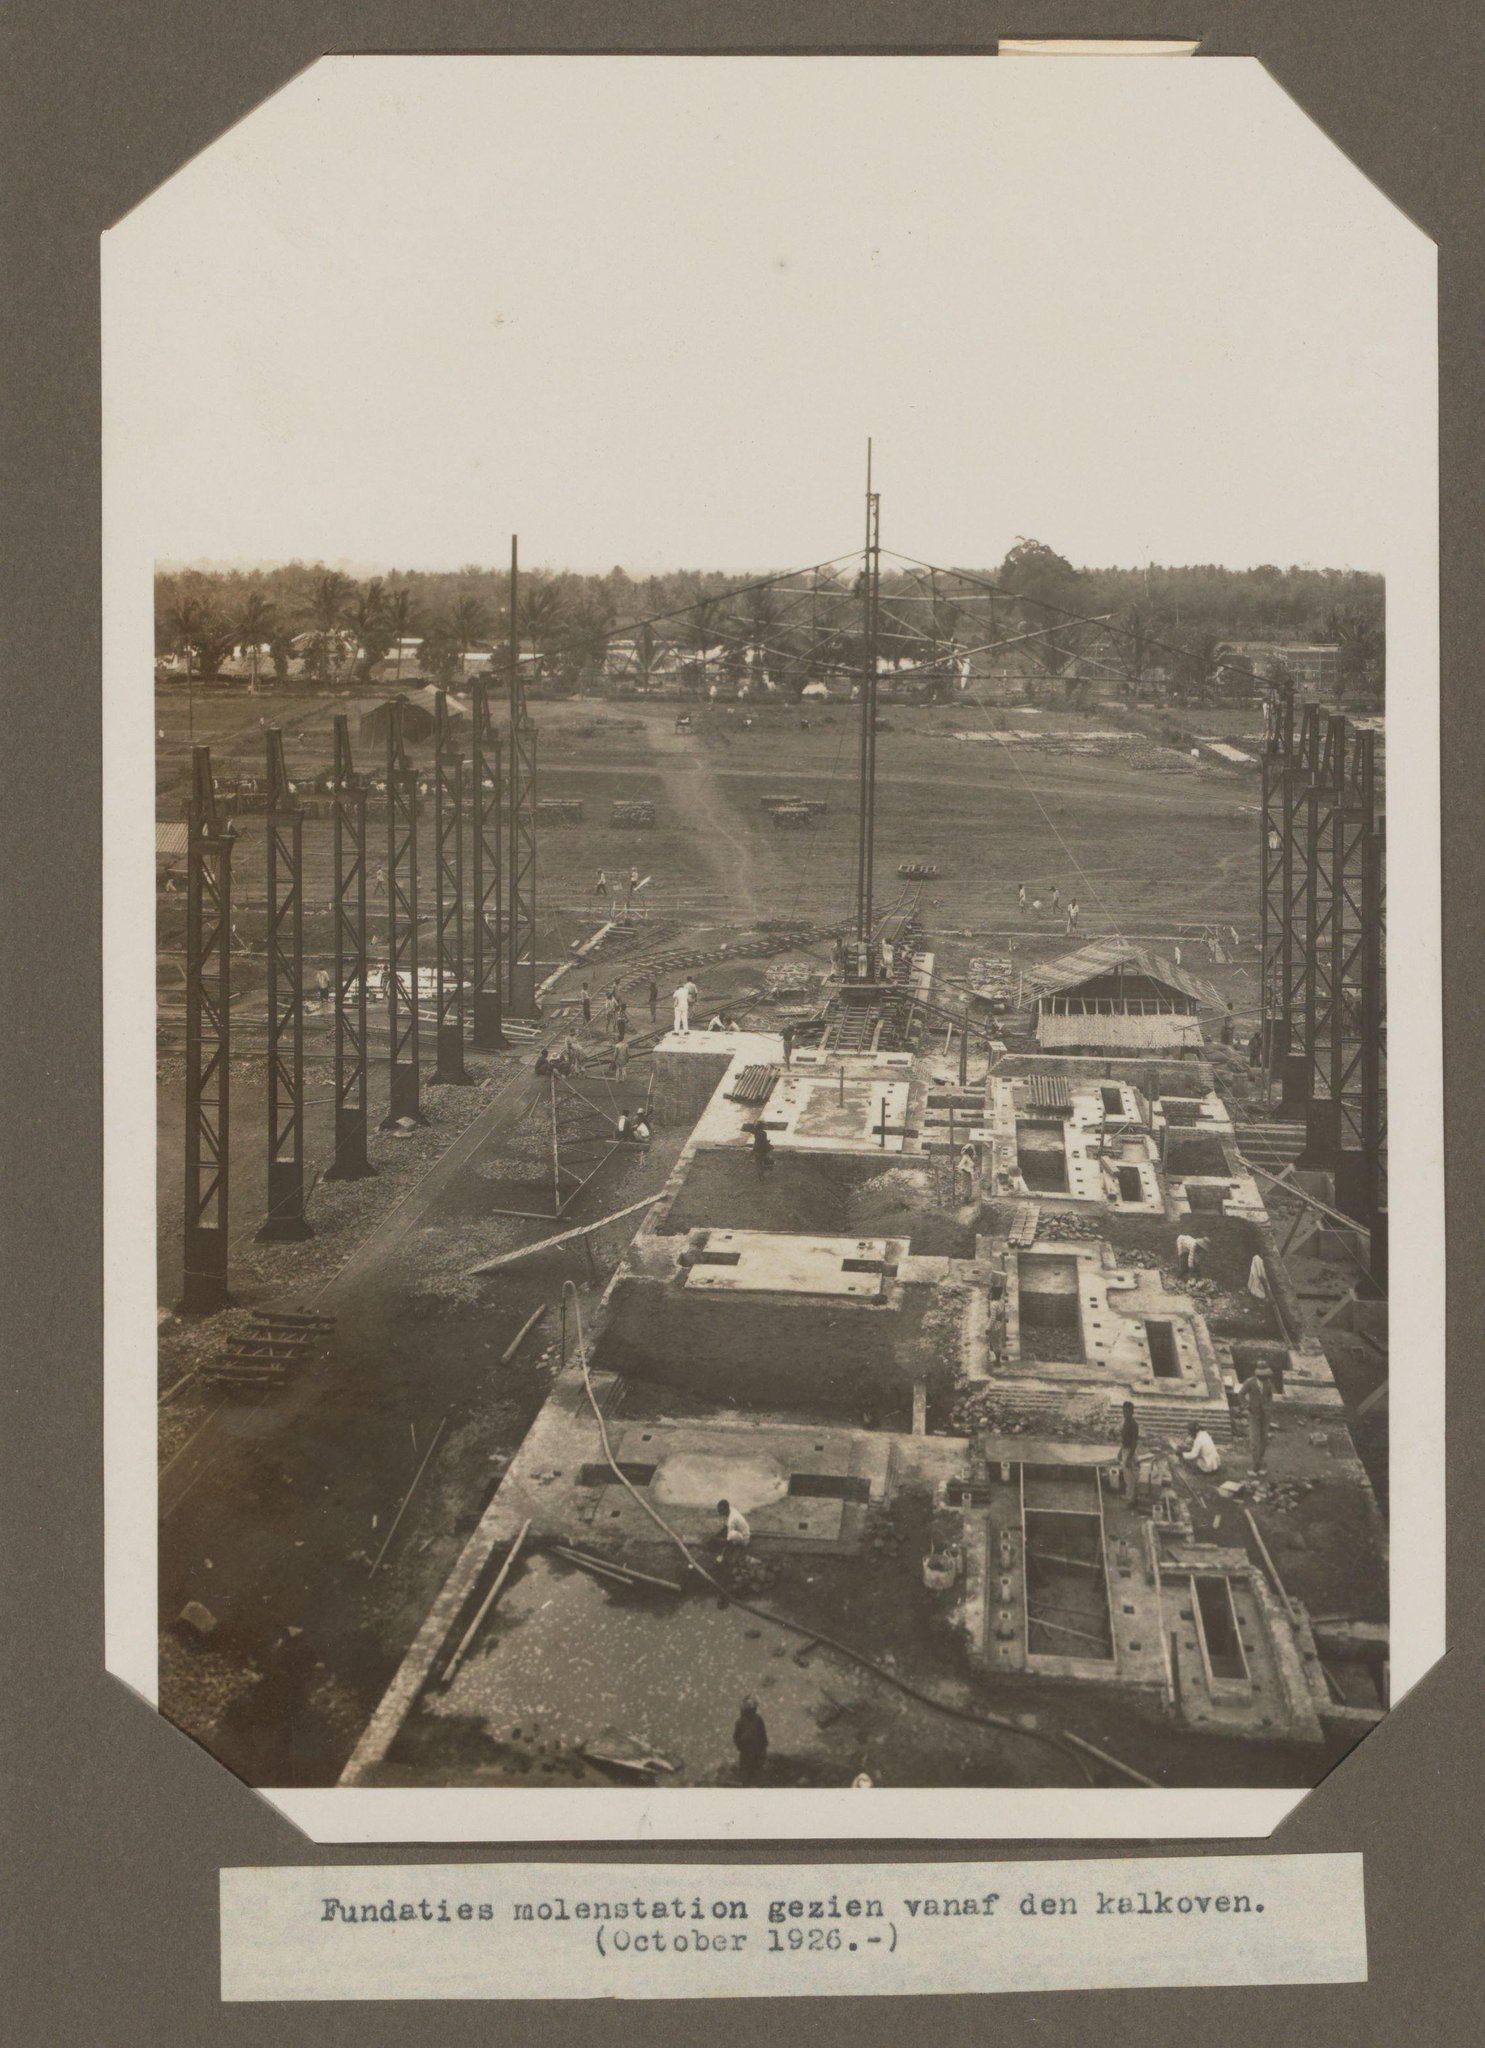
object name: photograph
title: Fundaties molenstation gezien vanaf den kalkoven. (October 1926.)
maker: Anonymous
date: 1910-1926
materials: photographic support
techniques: gelatin silver print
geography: east java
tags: colonial system, trade-company, industrial structures, (non-fruit) products of plants or trees: sugarcane, laying the foundations; trench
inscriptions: inscription: ‘Fundaties molenstation gezien vanaf den kalkoven. (October 1926.)’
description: Zicht op de funderingen voor het molenstation voor de fabriek, oktober 1926. Onderdeel van het fotoalbum met foto's van de opbouw van de suikerfabriek te Goenoengsari op Oost-Java door de Handels Vereniging Amsterdam 1926-1927.